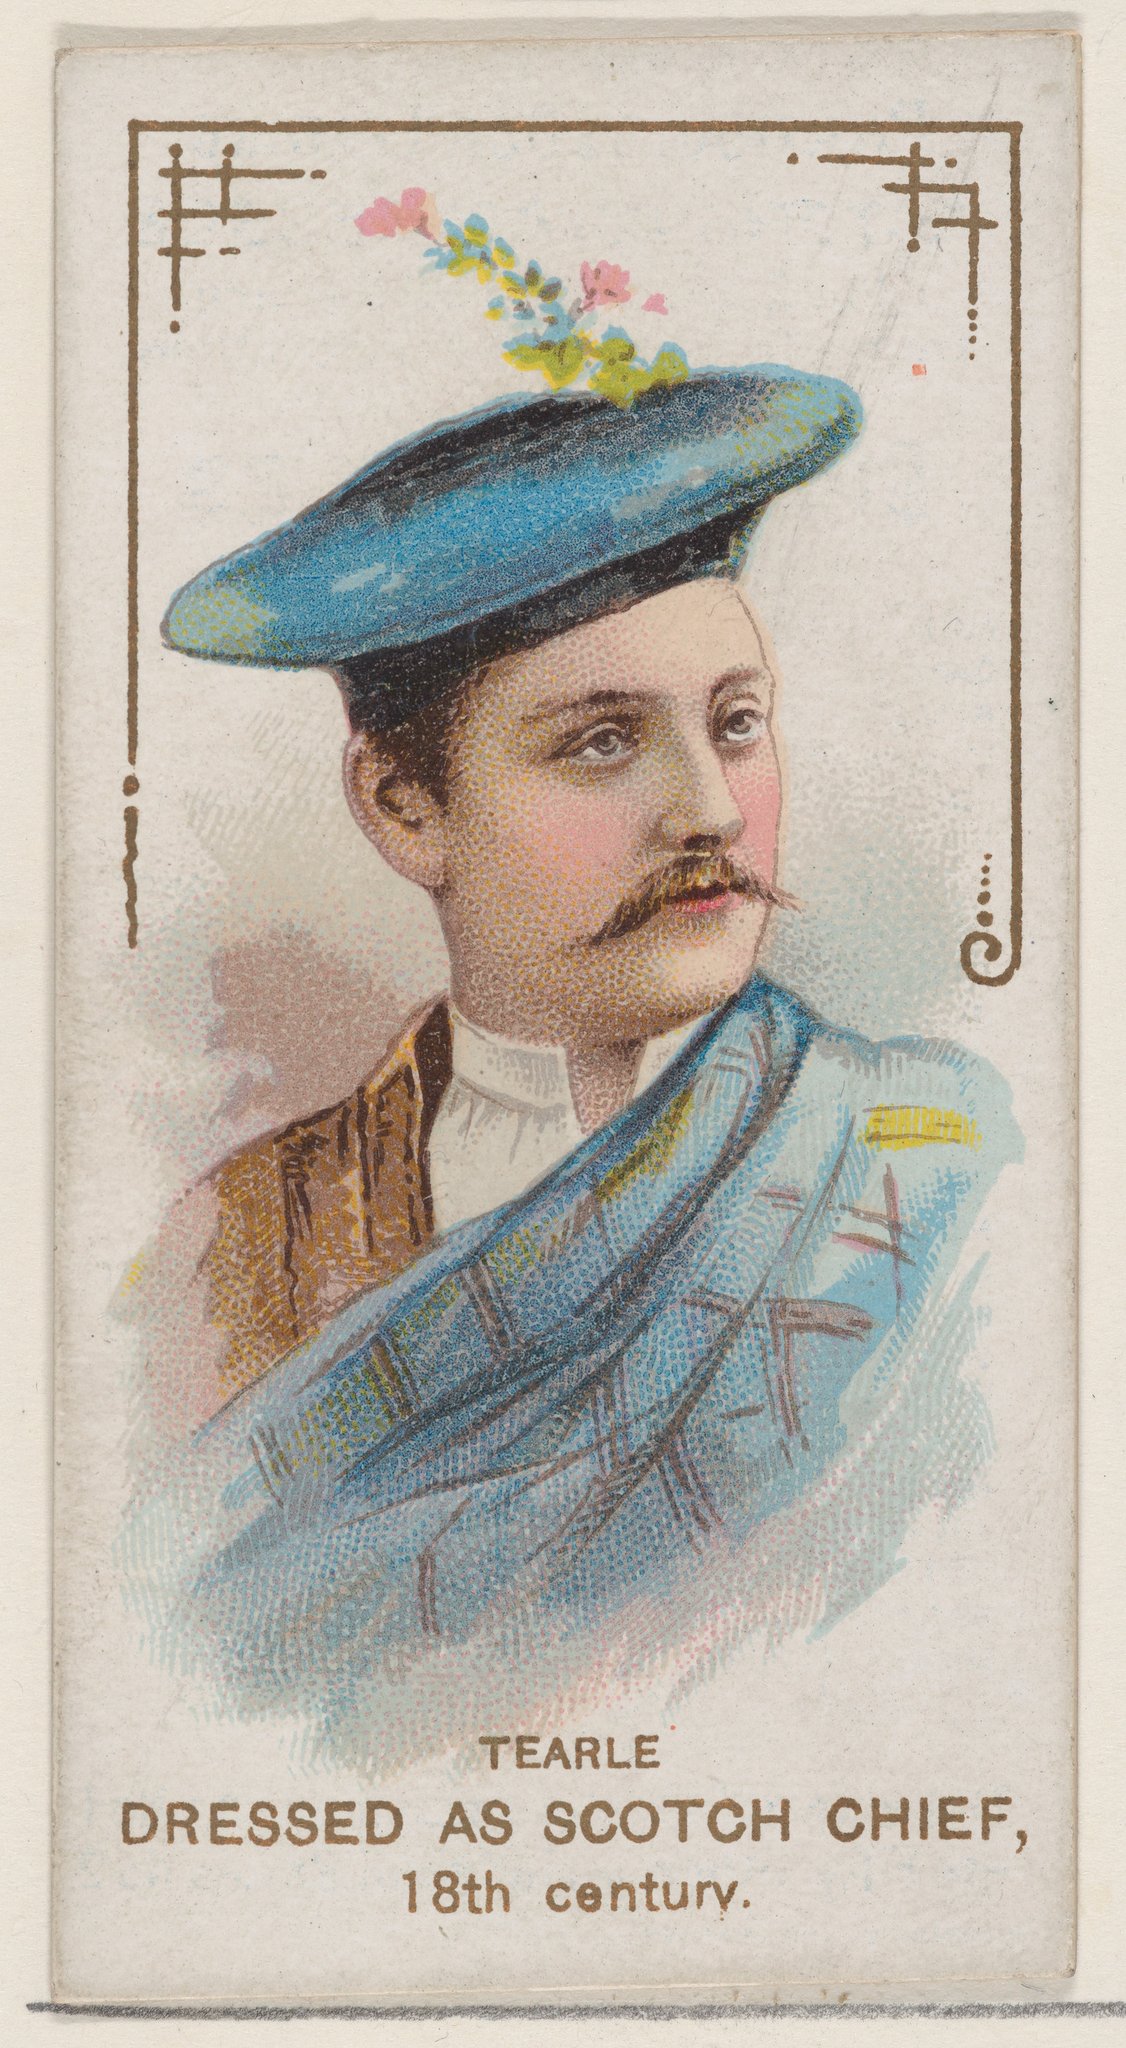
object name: print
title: Tearle Dressed as Scotch Chief of the 18th Century, from the set Actors and Actresses, First Series (N70) for Duke brand cigarettes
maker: w. duke, sons & co.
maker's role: publisher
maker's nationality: american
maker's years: 1870-1920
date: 1888-1889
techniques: color lithograph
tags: men,actors